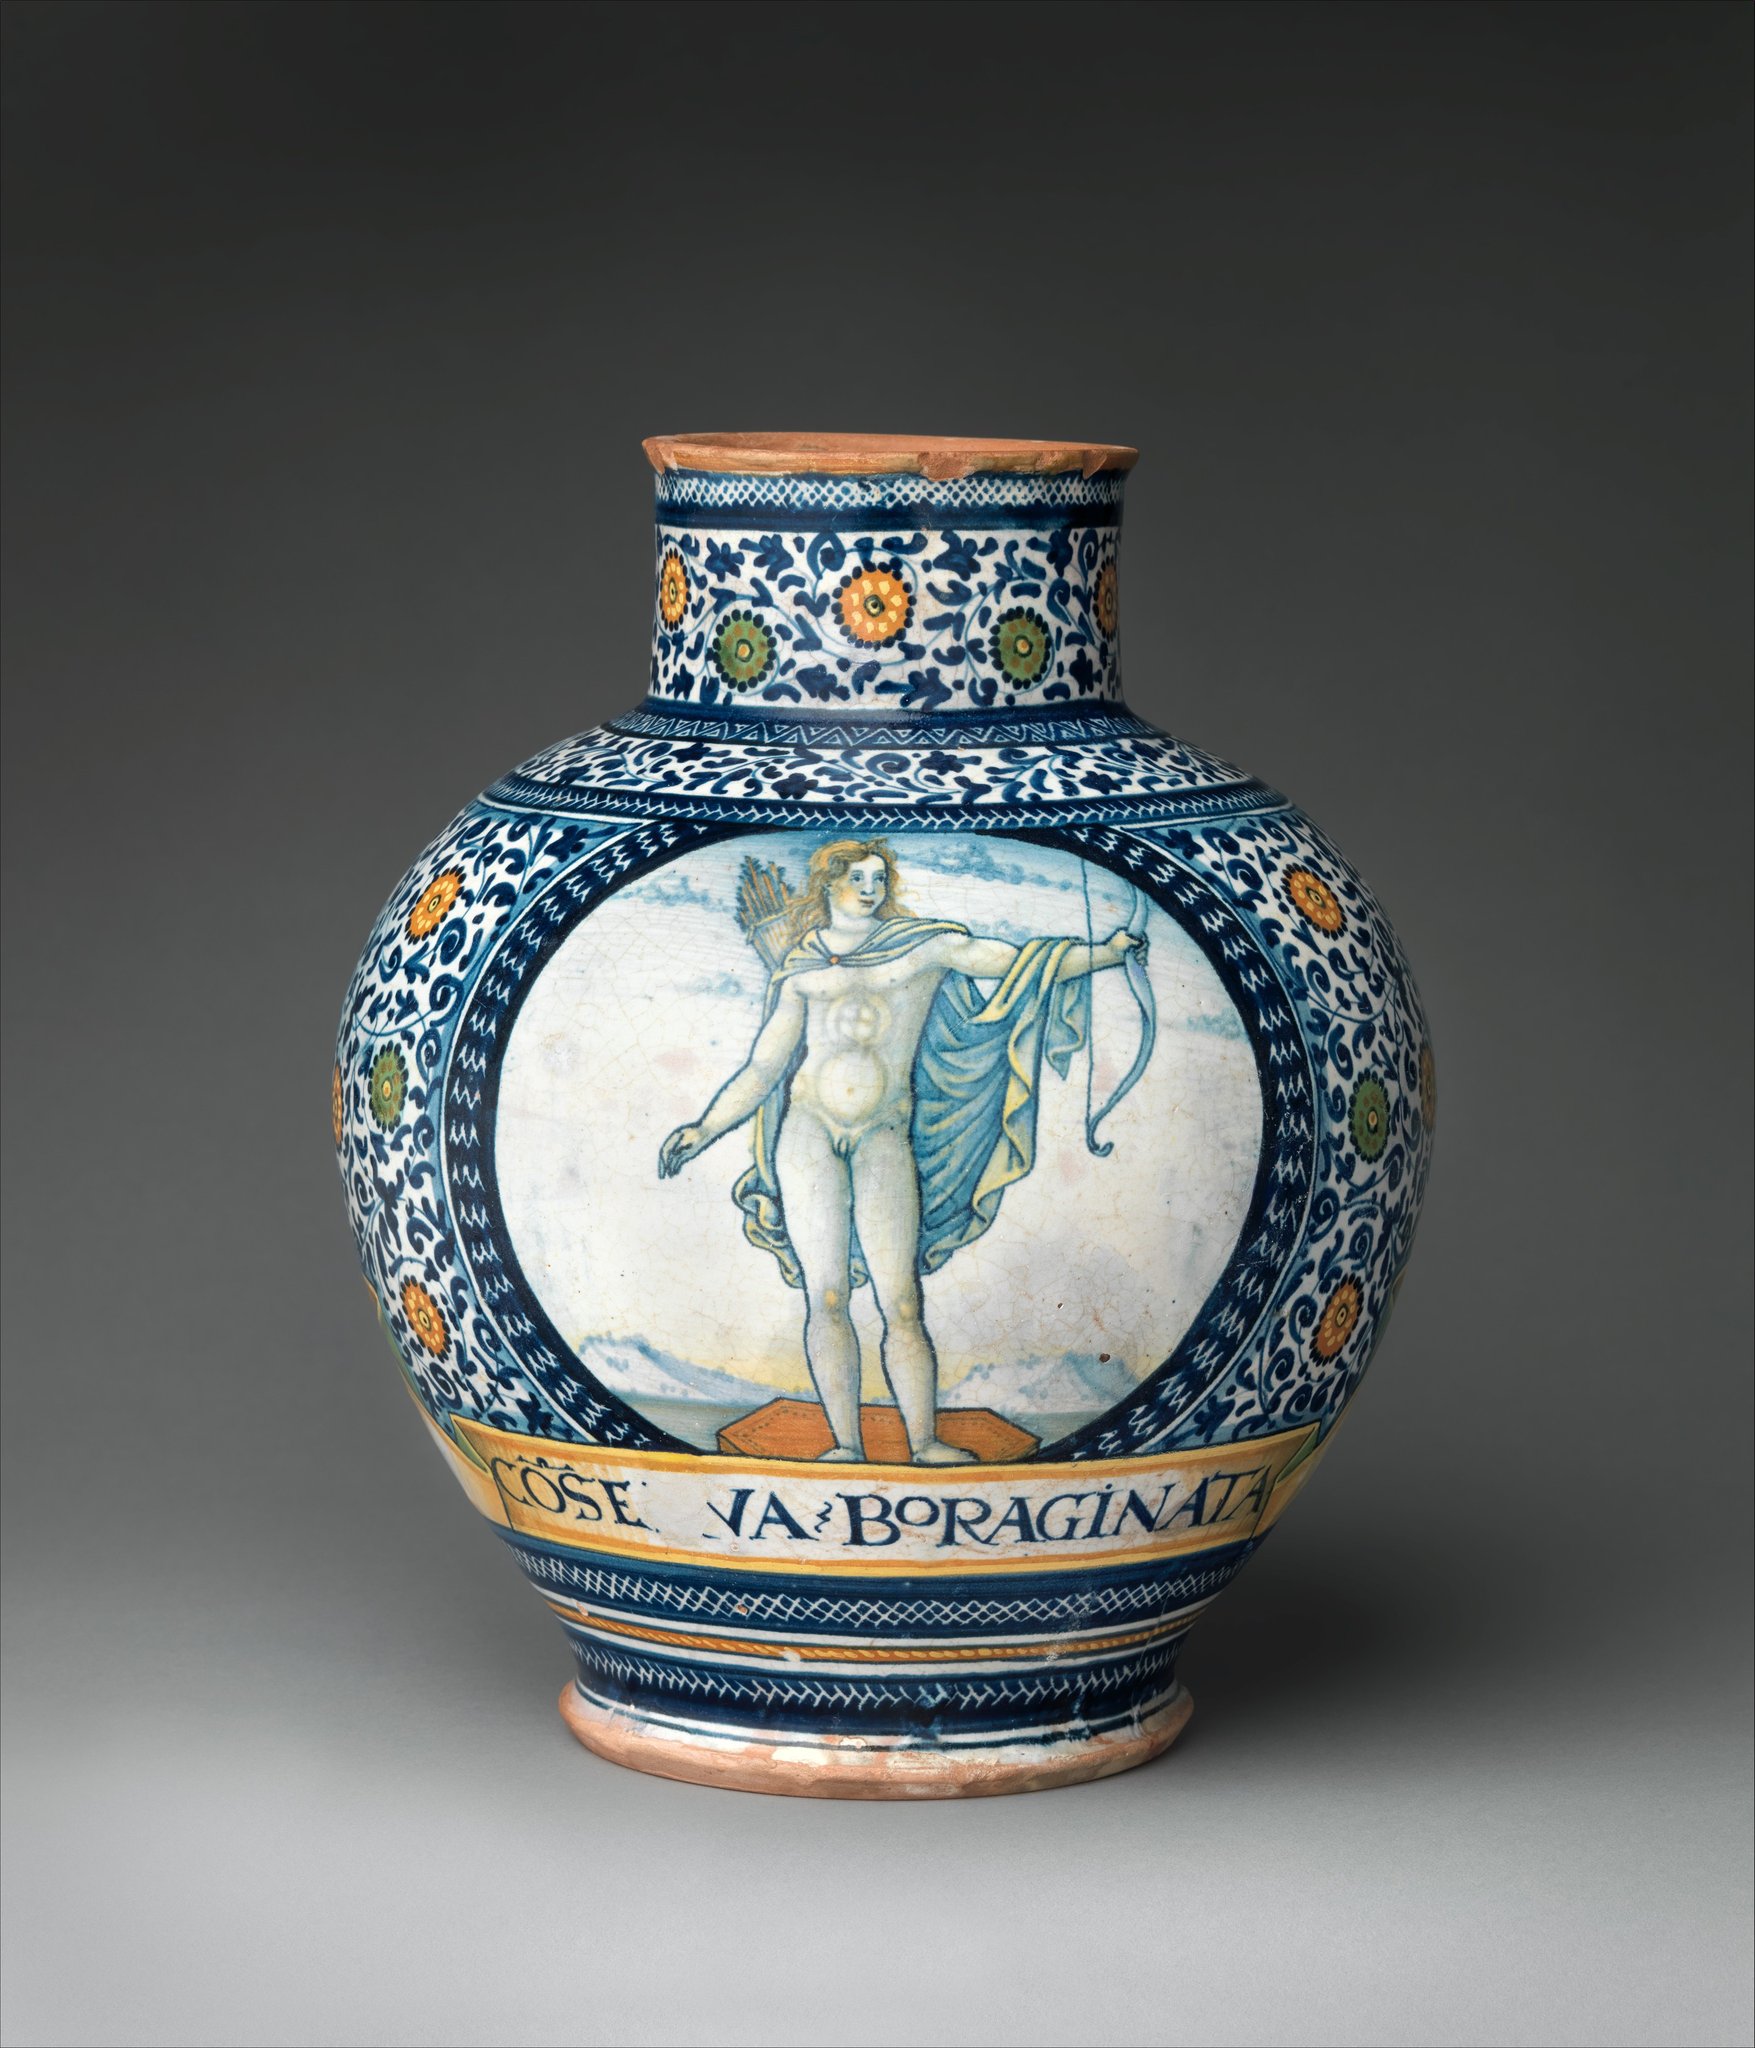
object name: pharmacy jar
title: Pharmacy jar with the Apollo Belvedere and King David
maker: nicoletto da modena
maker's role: artist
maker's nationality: italian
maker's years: 1500-1520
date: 1545-1550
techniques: maiolica, glazing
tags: apollo,flowers,david